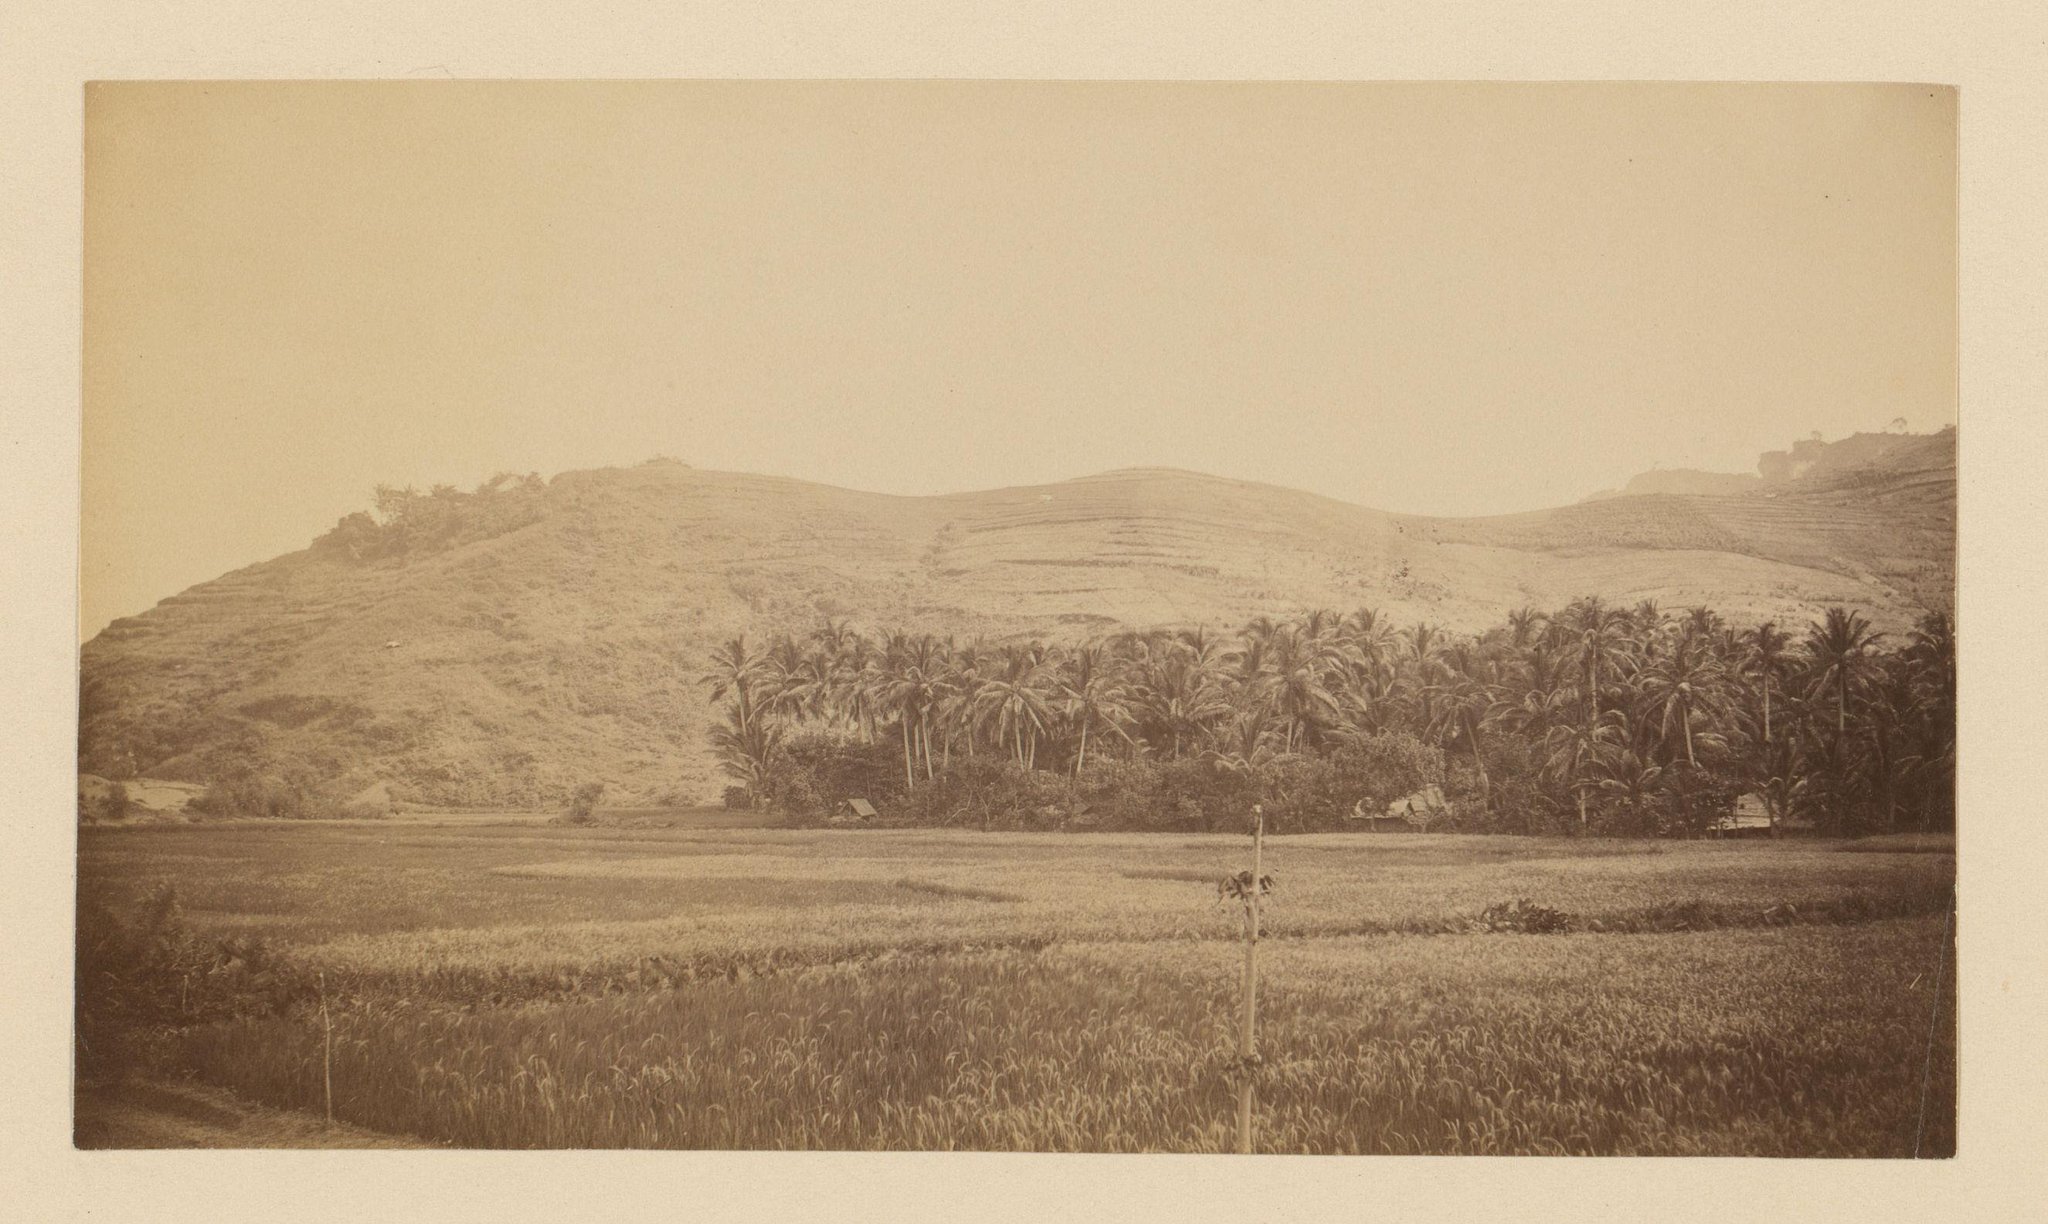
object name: photograph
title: Rijstveld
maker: Anonymous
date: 1851-1900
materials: cardboard, paper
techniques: albumen print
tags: sawahs, rice paddies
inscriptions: inscription: ‘FOTO’